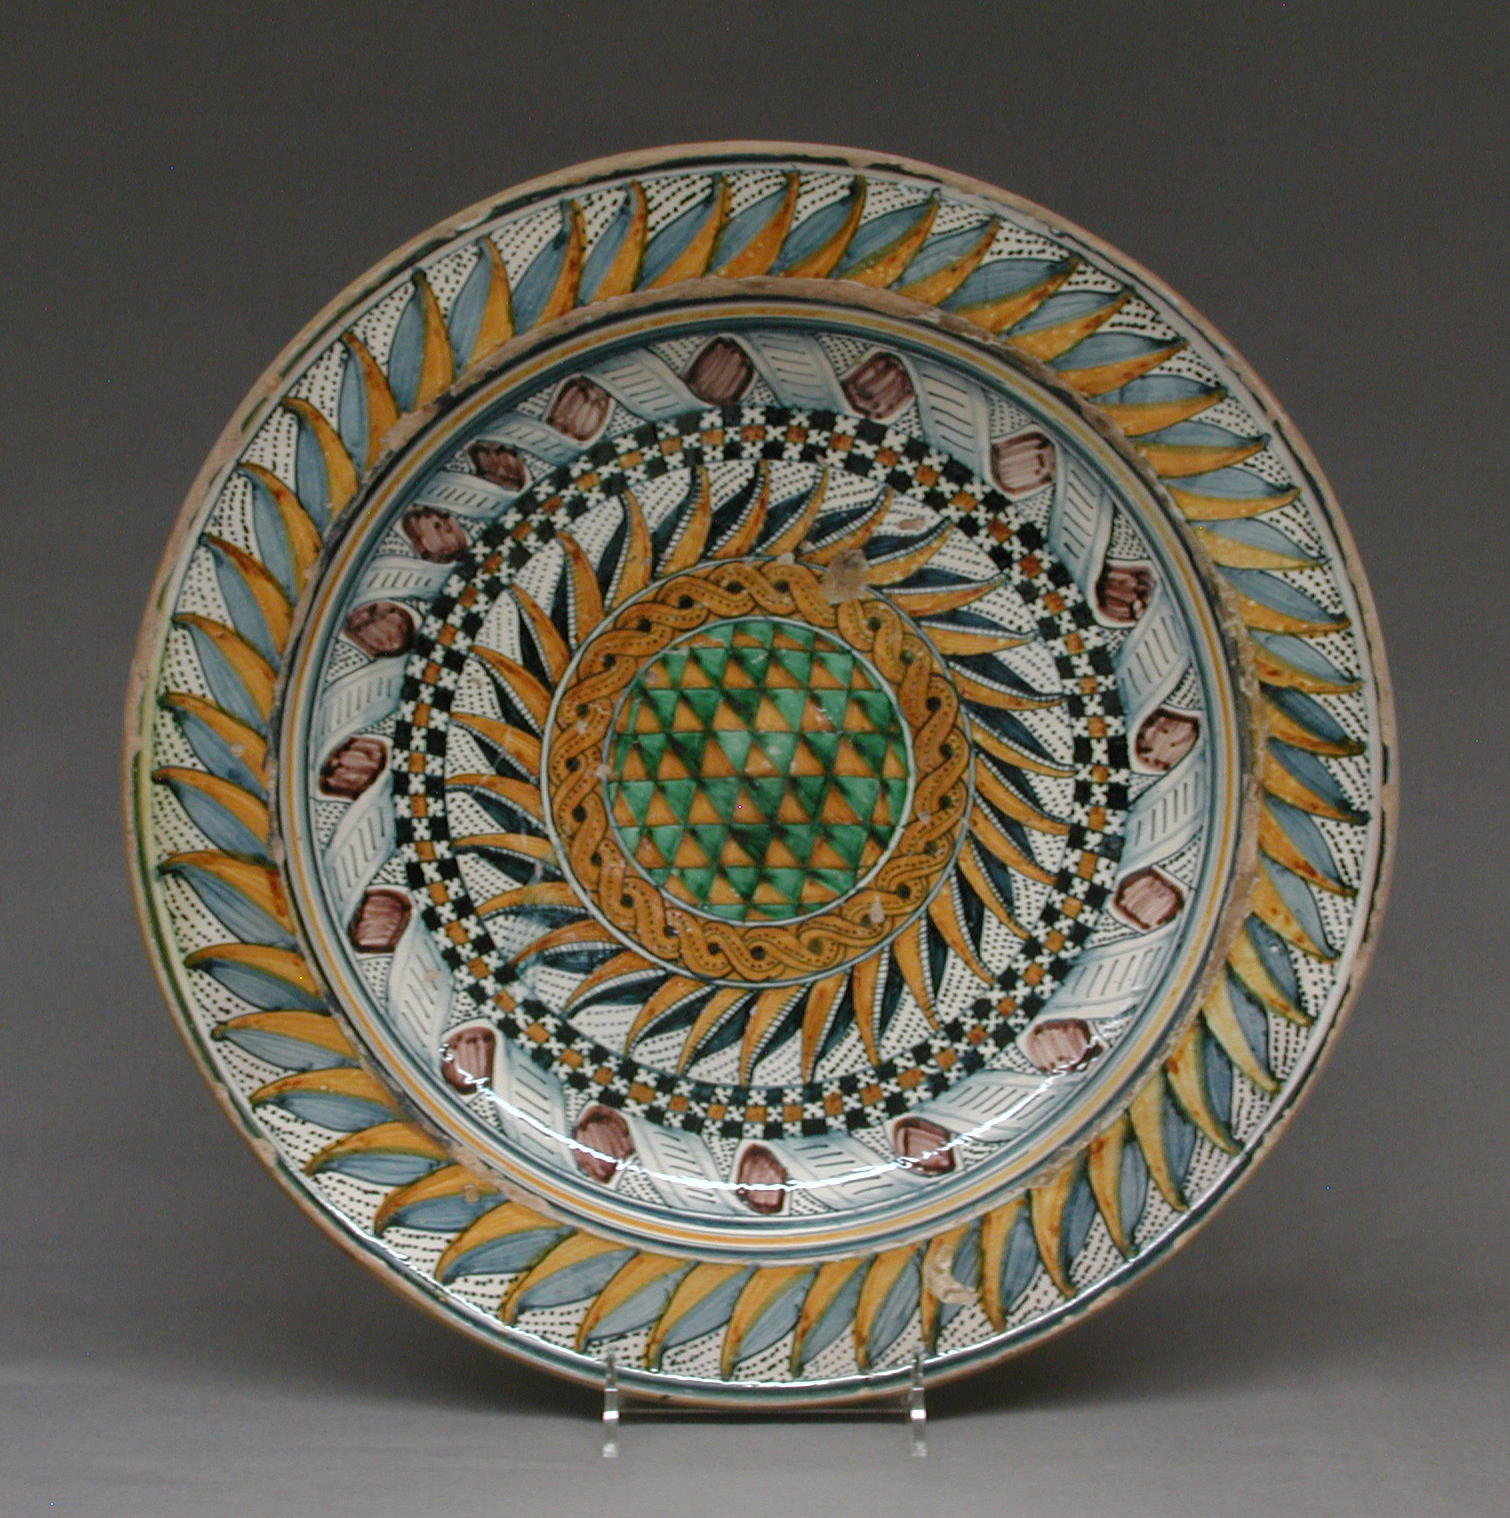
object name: dish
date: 1480-1500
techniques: maiolica, glazing